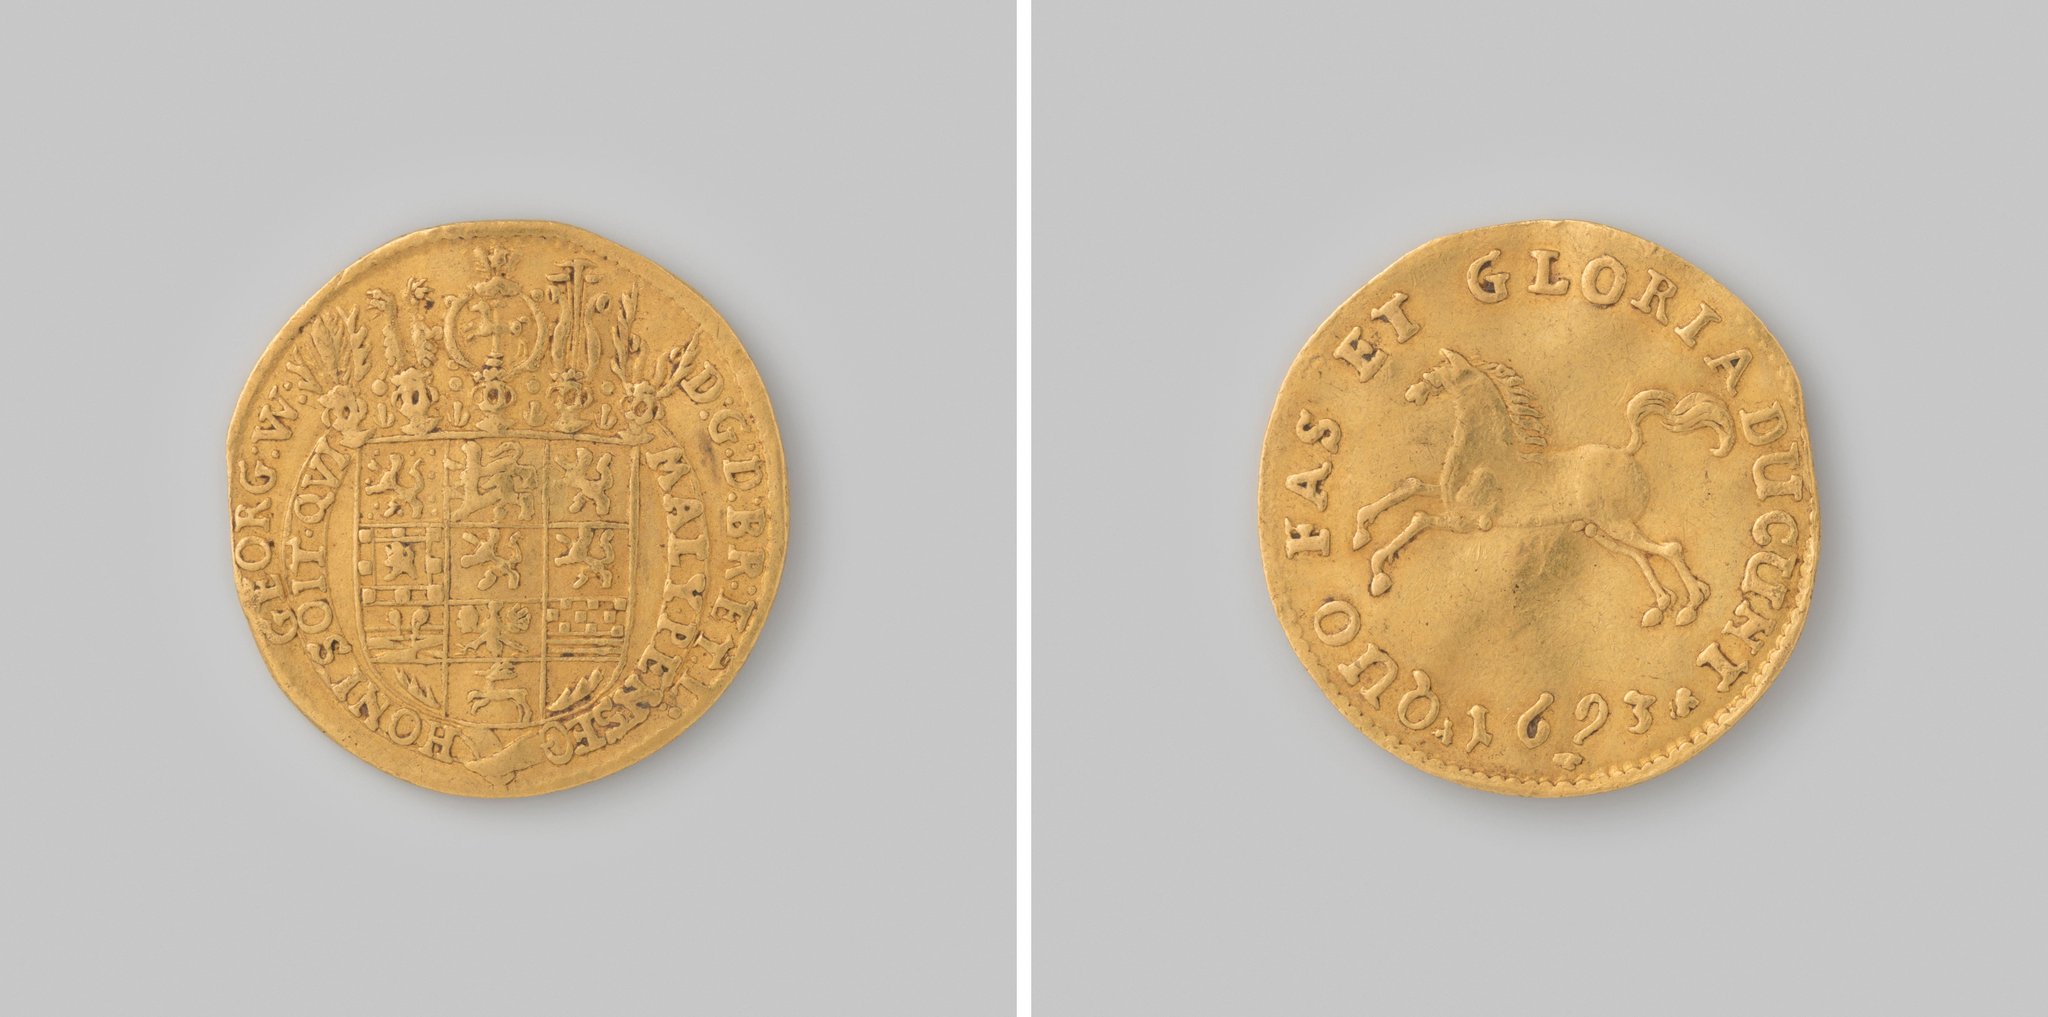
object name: ducat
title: Brunswijk-Luneburg-Celle, Georg Wilhelm, dukaat, 1693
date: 1693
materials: gold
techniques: striking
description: Gouden munt. Voorzijde: door orde van de kousenband omhangen en van helmtekens voorzien samengesteld wapenschild. Keerzijde: paard in galop naar links. Daaronder jaartal in omschrift. Gladde rand.